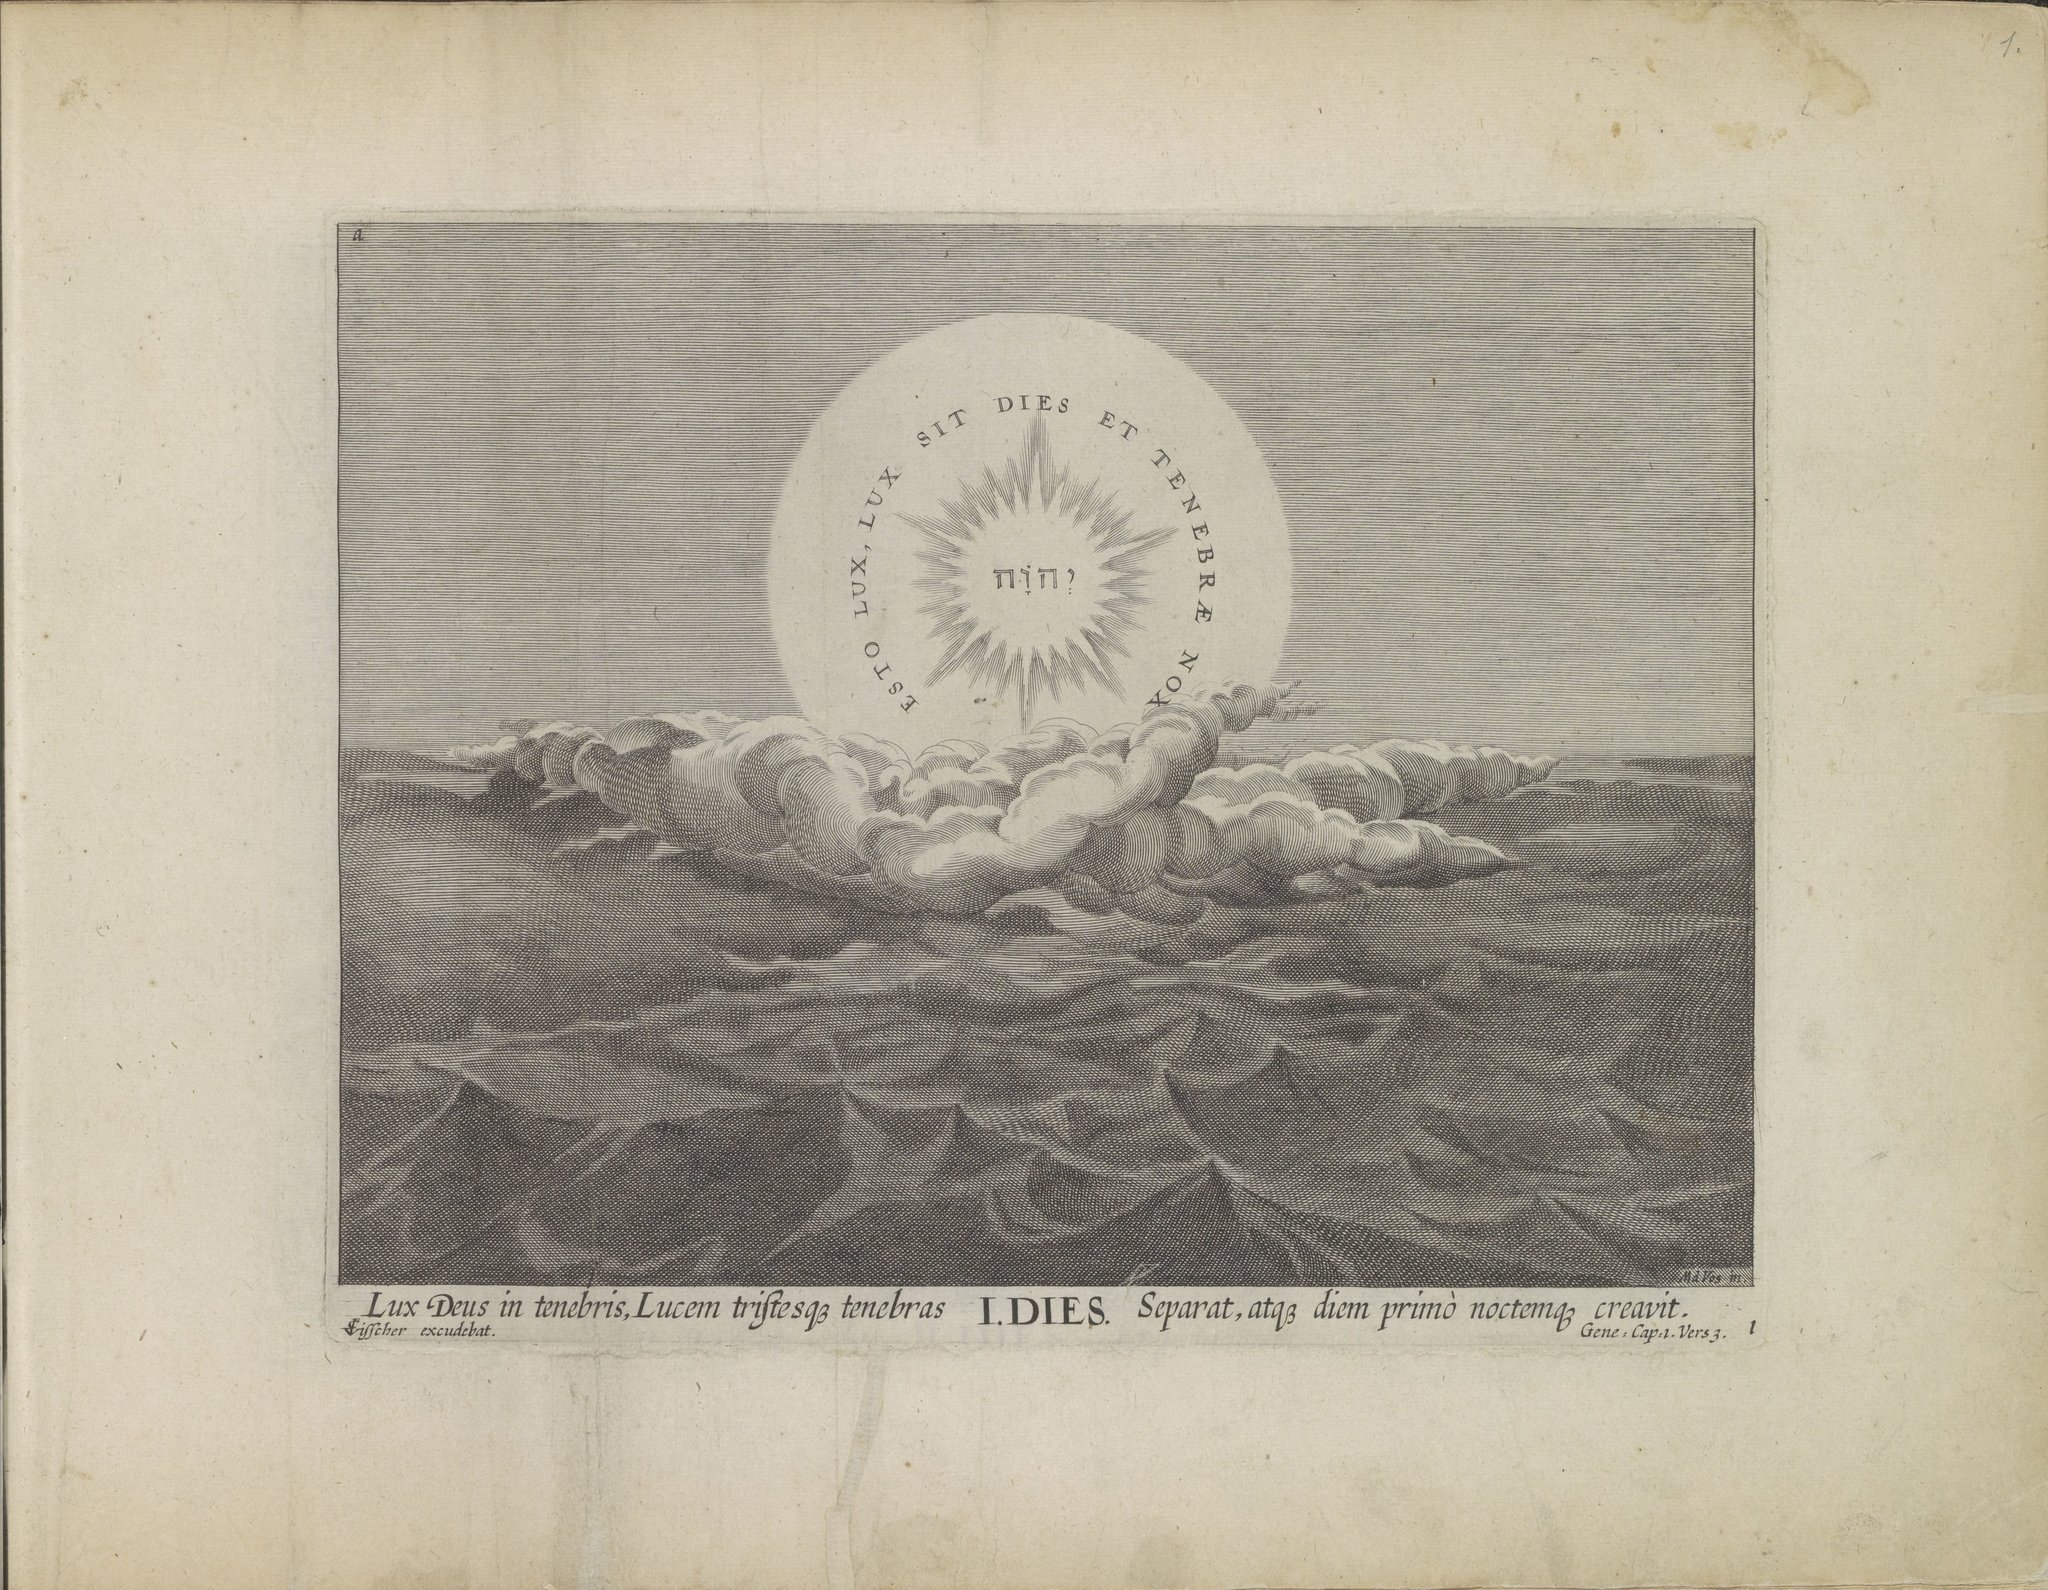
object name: album leaf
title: Eerste scheppingsdag: scheiding van licht en duisternis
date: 1639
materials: paper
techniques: engraving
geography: amsterdam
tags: division of light and darkness, tetragram (in roman or hebrew script) ~ symbol of god the father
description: God zweeft in de vorm van een tetragram op een wolk: boven hem is er licht, onder hem duisternis. Op de eerste dag van de schepping schiep God licht en duisternis. Onder de voorstelling een verwijzing in het Latijn naar de Bijbeltekst in Gen. 1:3. Deze prent maakt deel uit van een album.